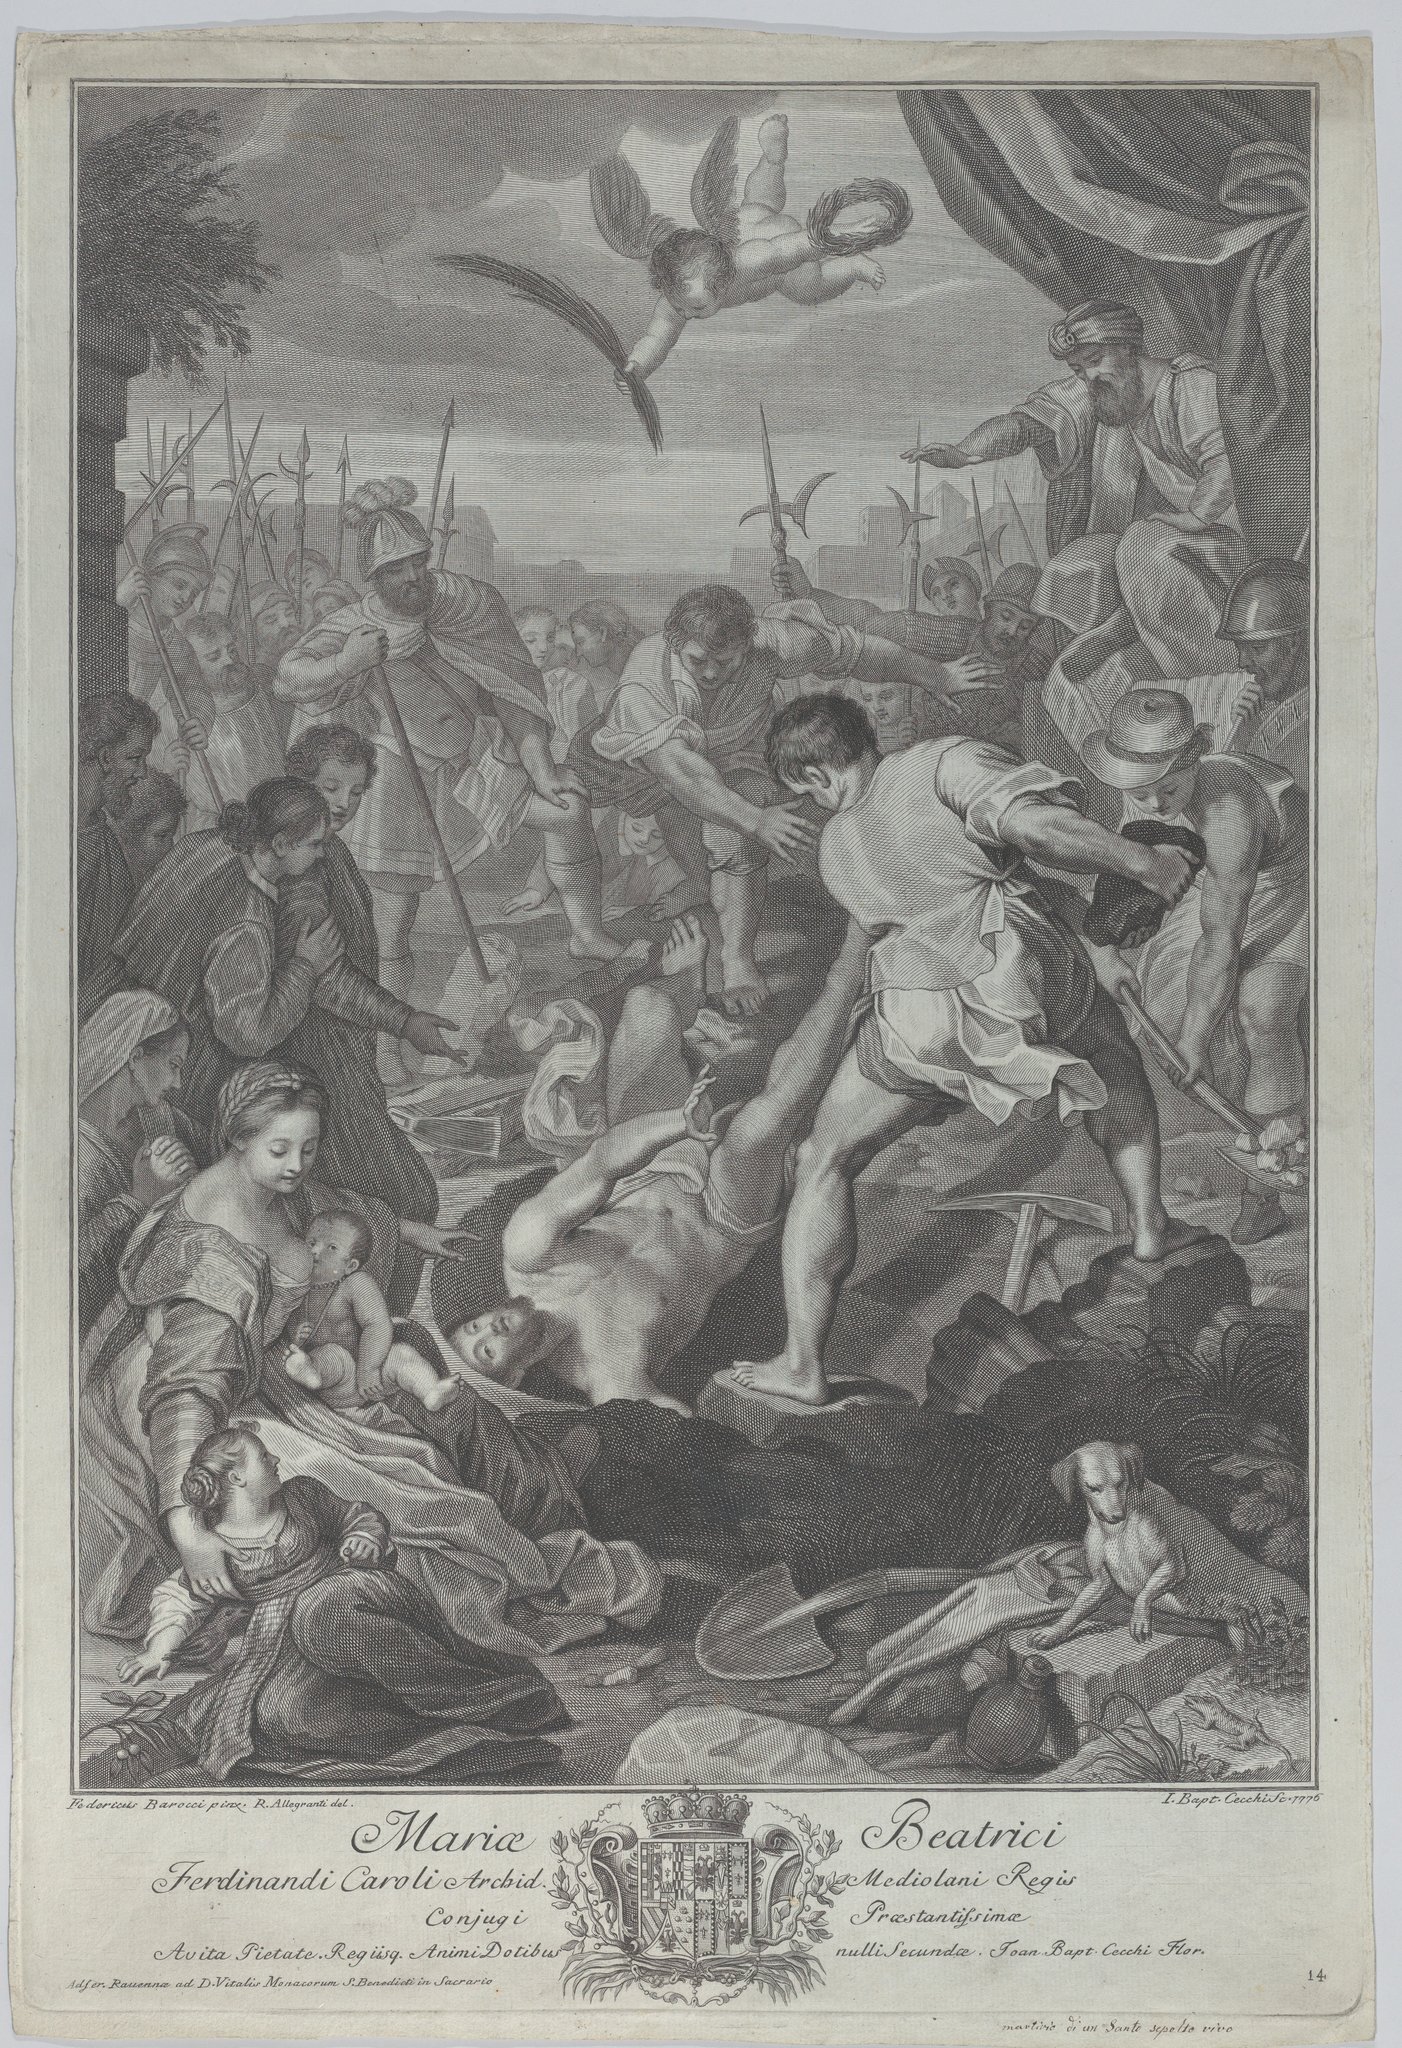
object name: print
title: The martyrdom of Saint Vitalis of Milan, who is being buried alive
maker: giovanni battista cecchi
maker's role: artist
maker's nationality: italian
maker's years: 1748-1820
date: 1776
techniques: engraving